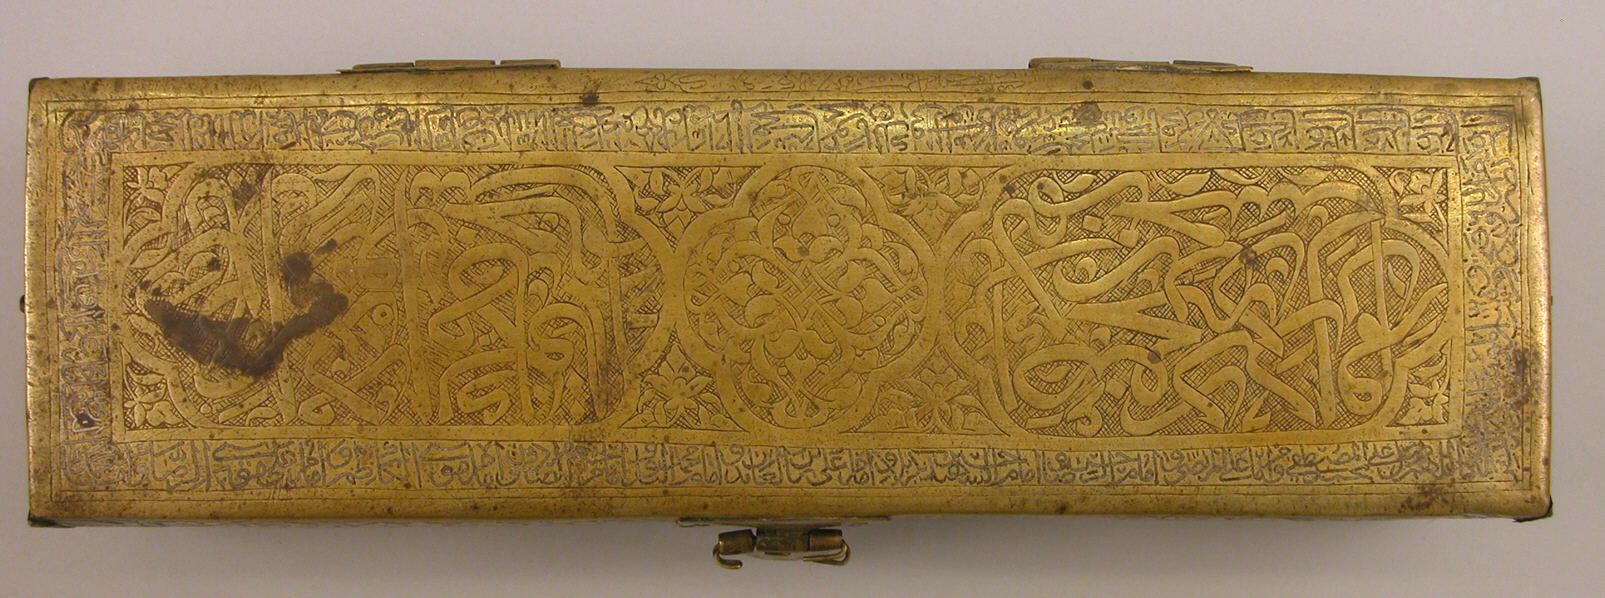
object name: pen box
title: Pen Box (Qalamdan) with Inscriptions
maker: hasan ramadan shahi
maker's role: calligrapher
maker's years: 1450-1550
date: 1501-1533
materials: brass, silver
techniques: chasing, engraving, inlay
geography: iran